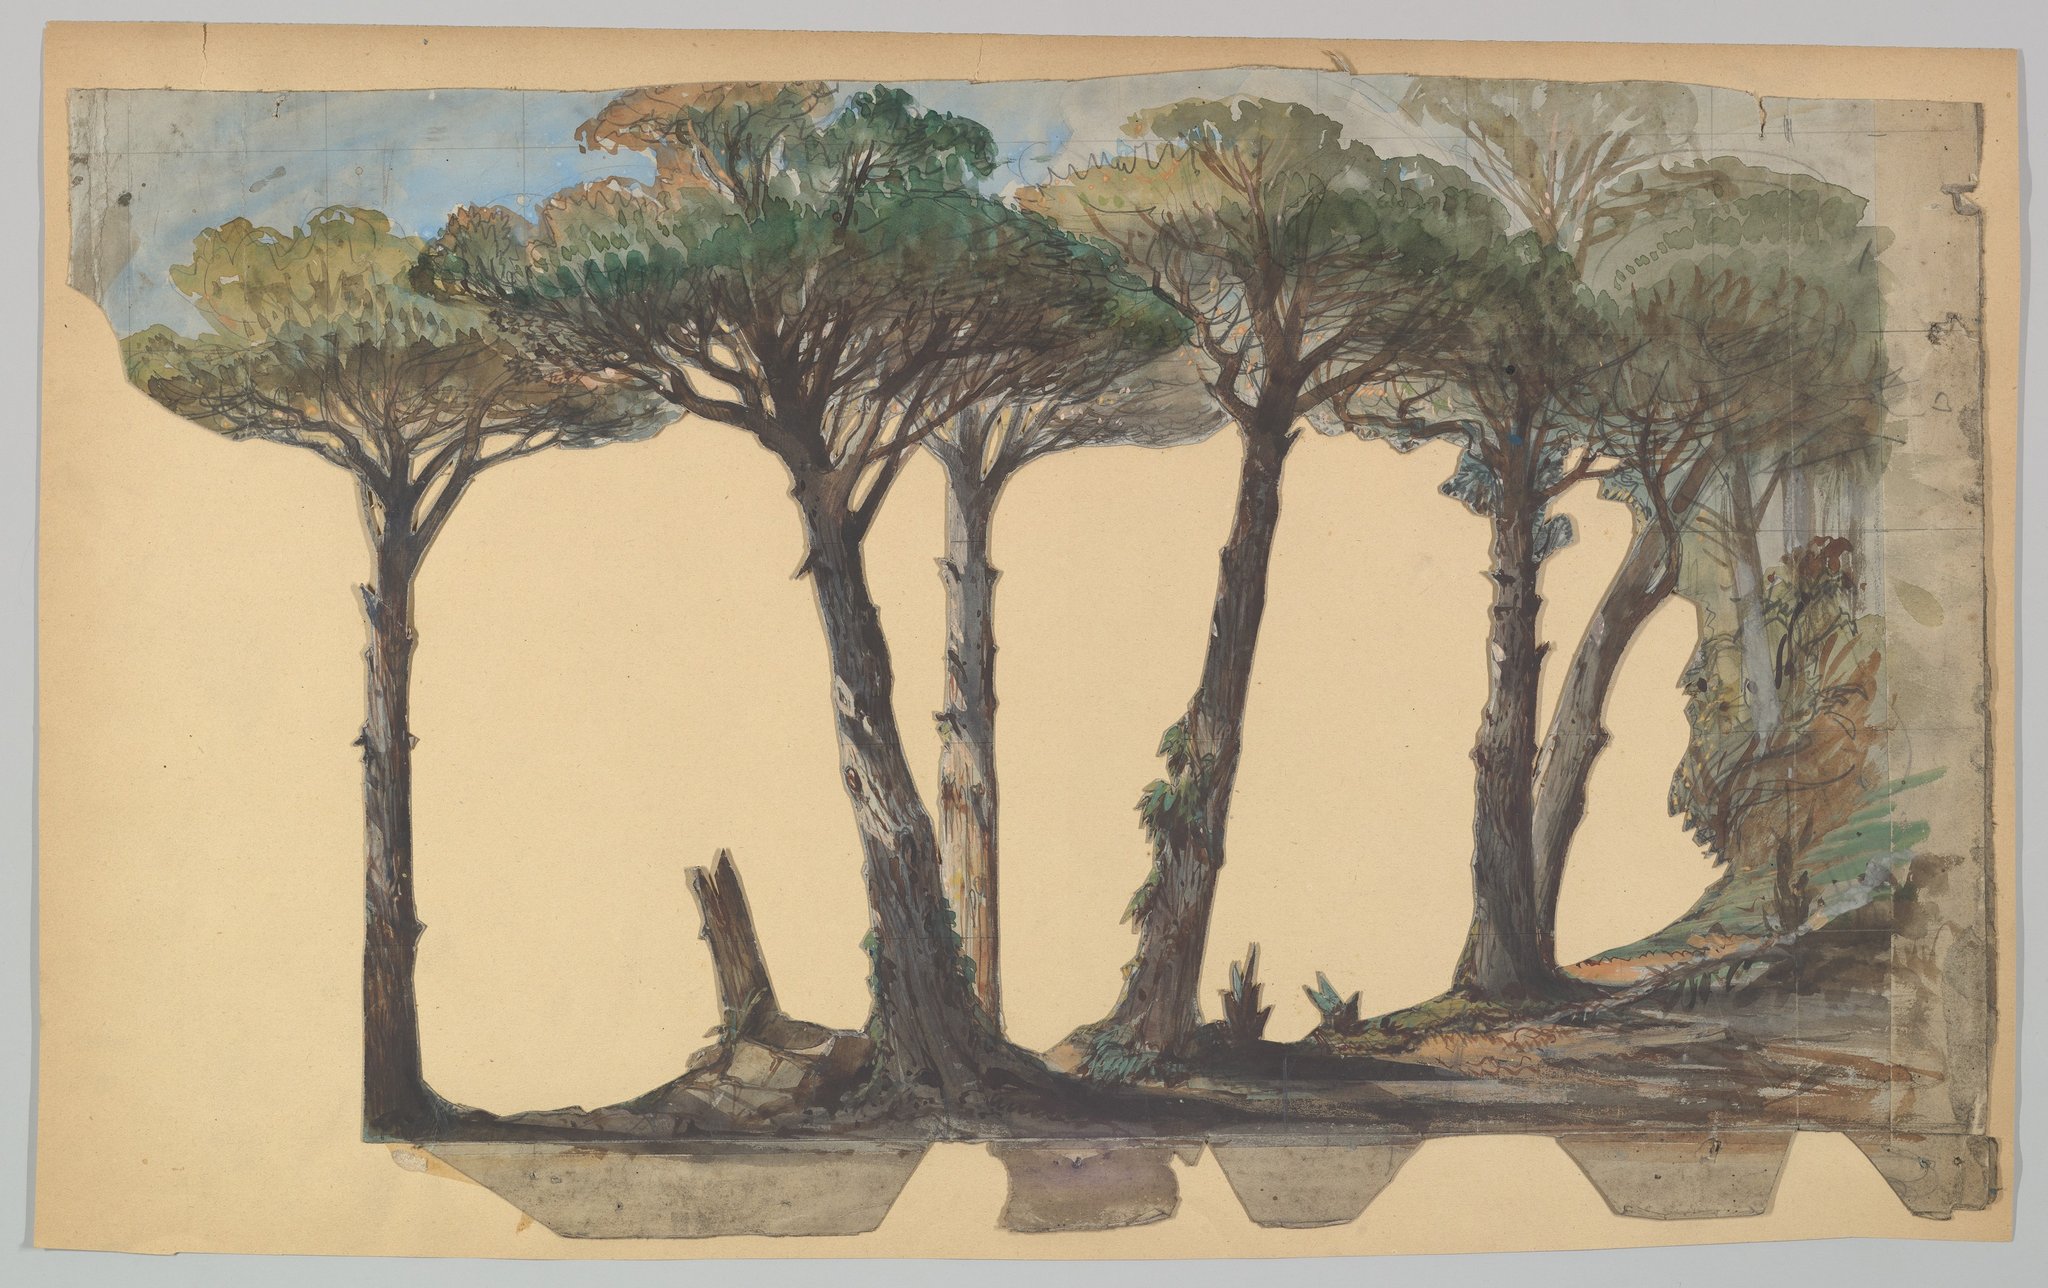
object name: drawing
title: Design for a Stage Set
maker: eugène cicéri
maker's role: artist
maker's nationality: french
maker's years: 1813-1890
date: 1830-1890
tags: trees,stage design